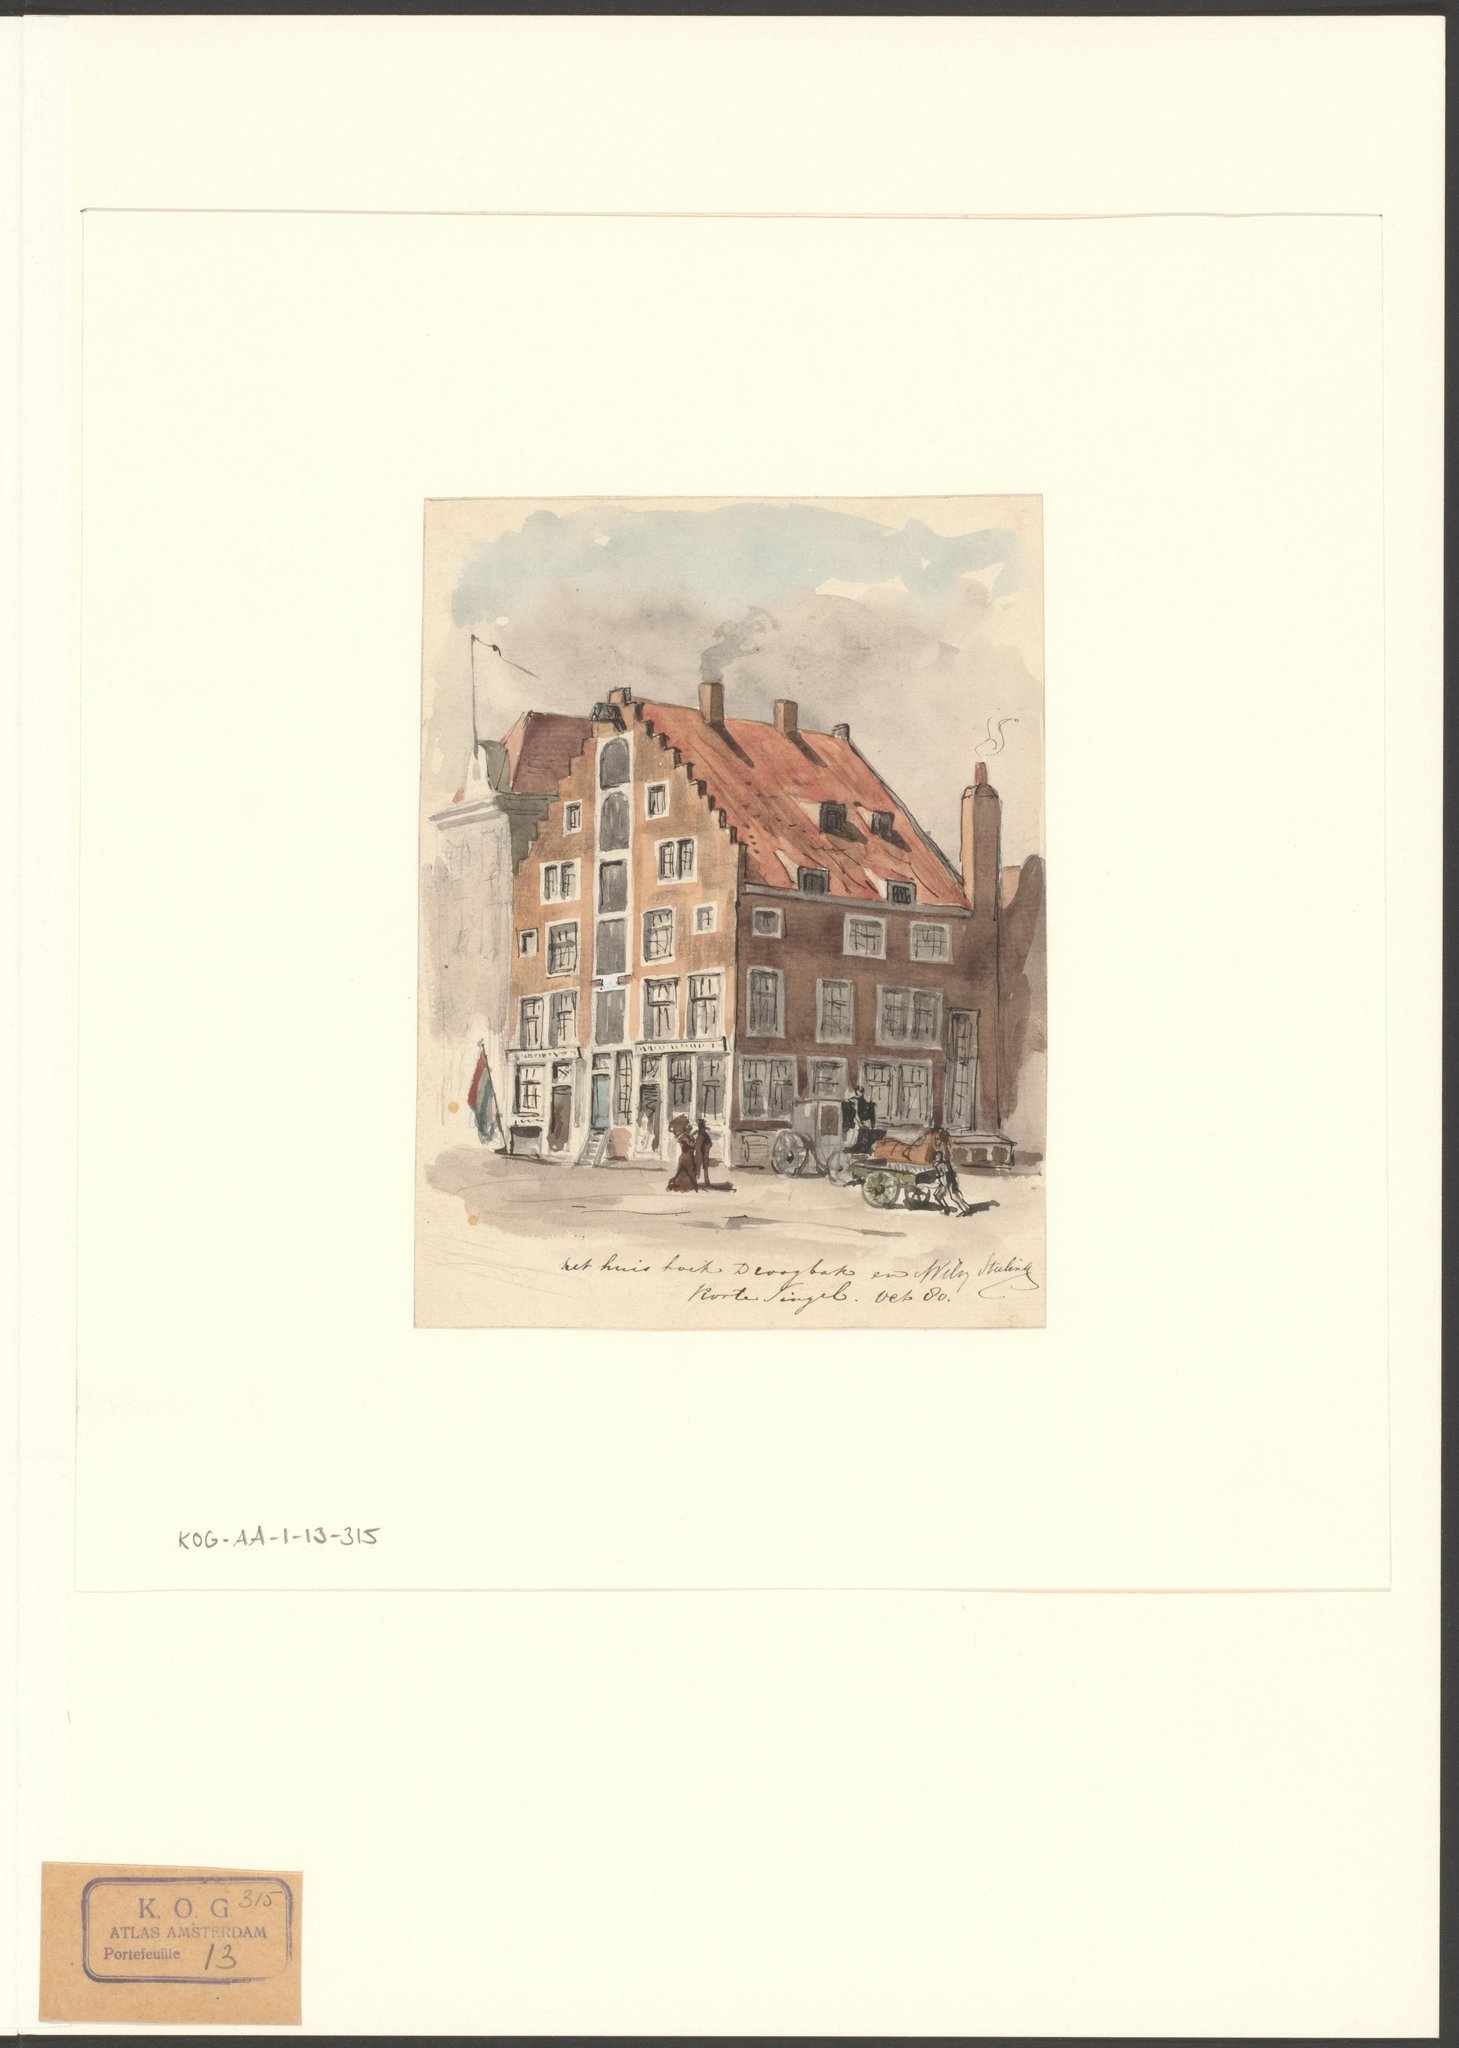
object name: drawing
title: Gezicht op Singel 2A, hoek Droogbak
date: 1810-1880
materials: ink, paper, pencil, watercolor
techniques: brush, pen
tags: city-view in general; 'veduta', façade (of house or building), street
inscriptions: signature, date and inscription: ‘het huis hoek Droogbak en / Korte Singel / Wilm Steelink / Oct 80’, collector's mark: ‘13’ Lugt 1641b, inscription: ‘Port. 13-315’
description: Onderwerpsrubriek binnen de Atlas Amsterdam: Oude Schans, Schoutensteeg, Singel (Korte), Singel.